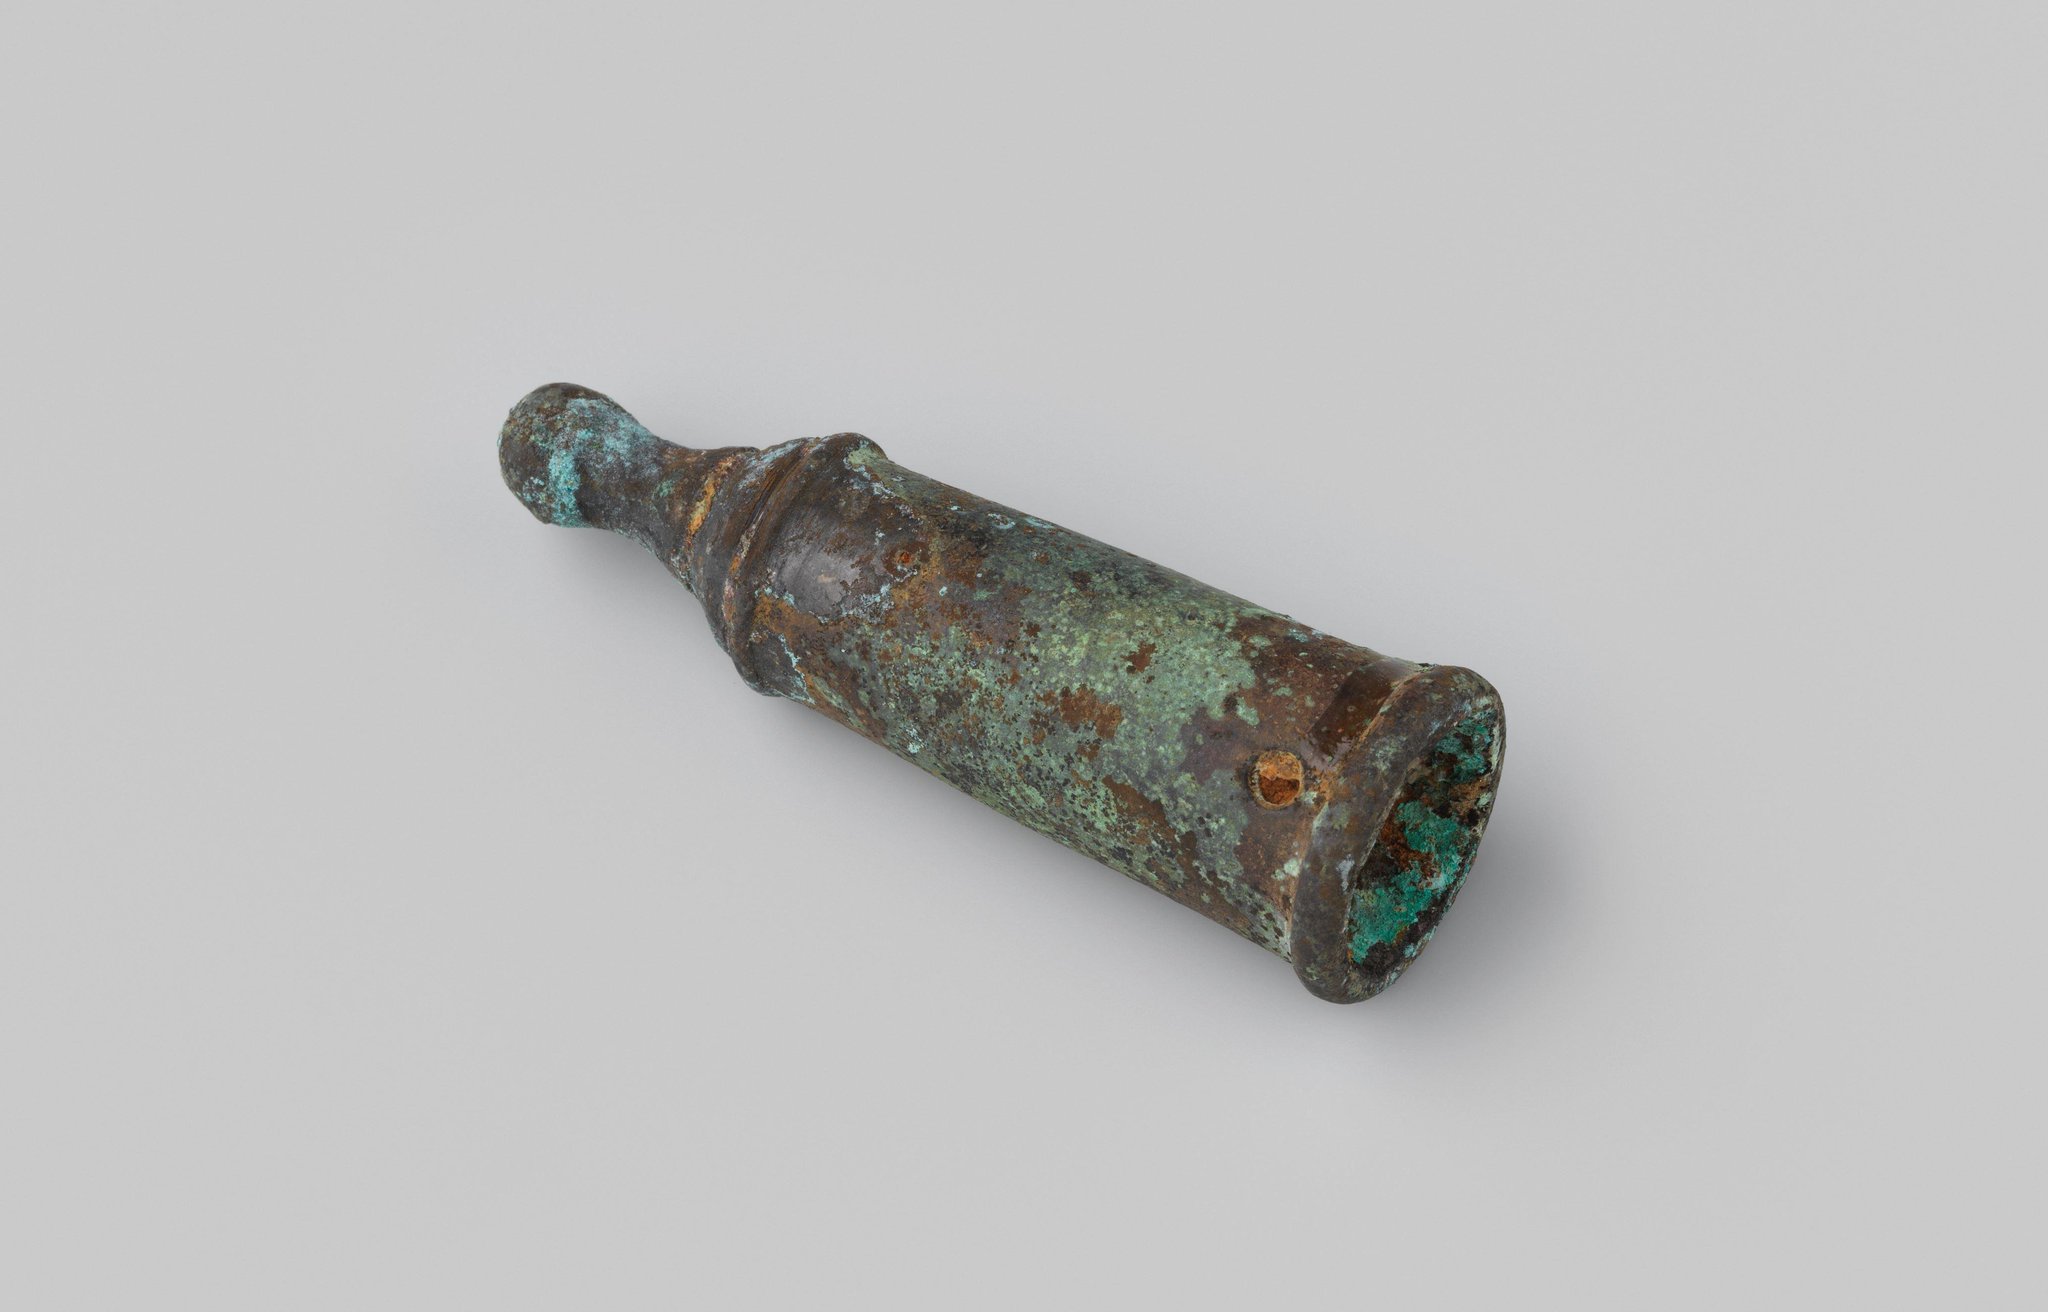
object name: clamp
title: Klem afkomstig uit het wrak van de Oost-Indiëvaarder Hollandia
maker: Anonymous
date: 1700-1743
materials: copper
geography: netherlands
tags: verenigde oostindische compagnie, hollandia (schip)